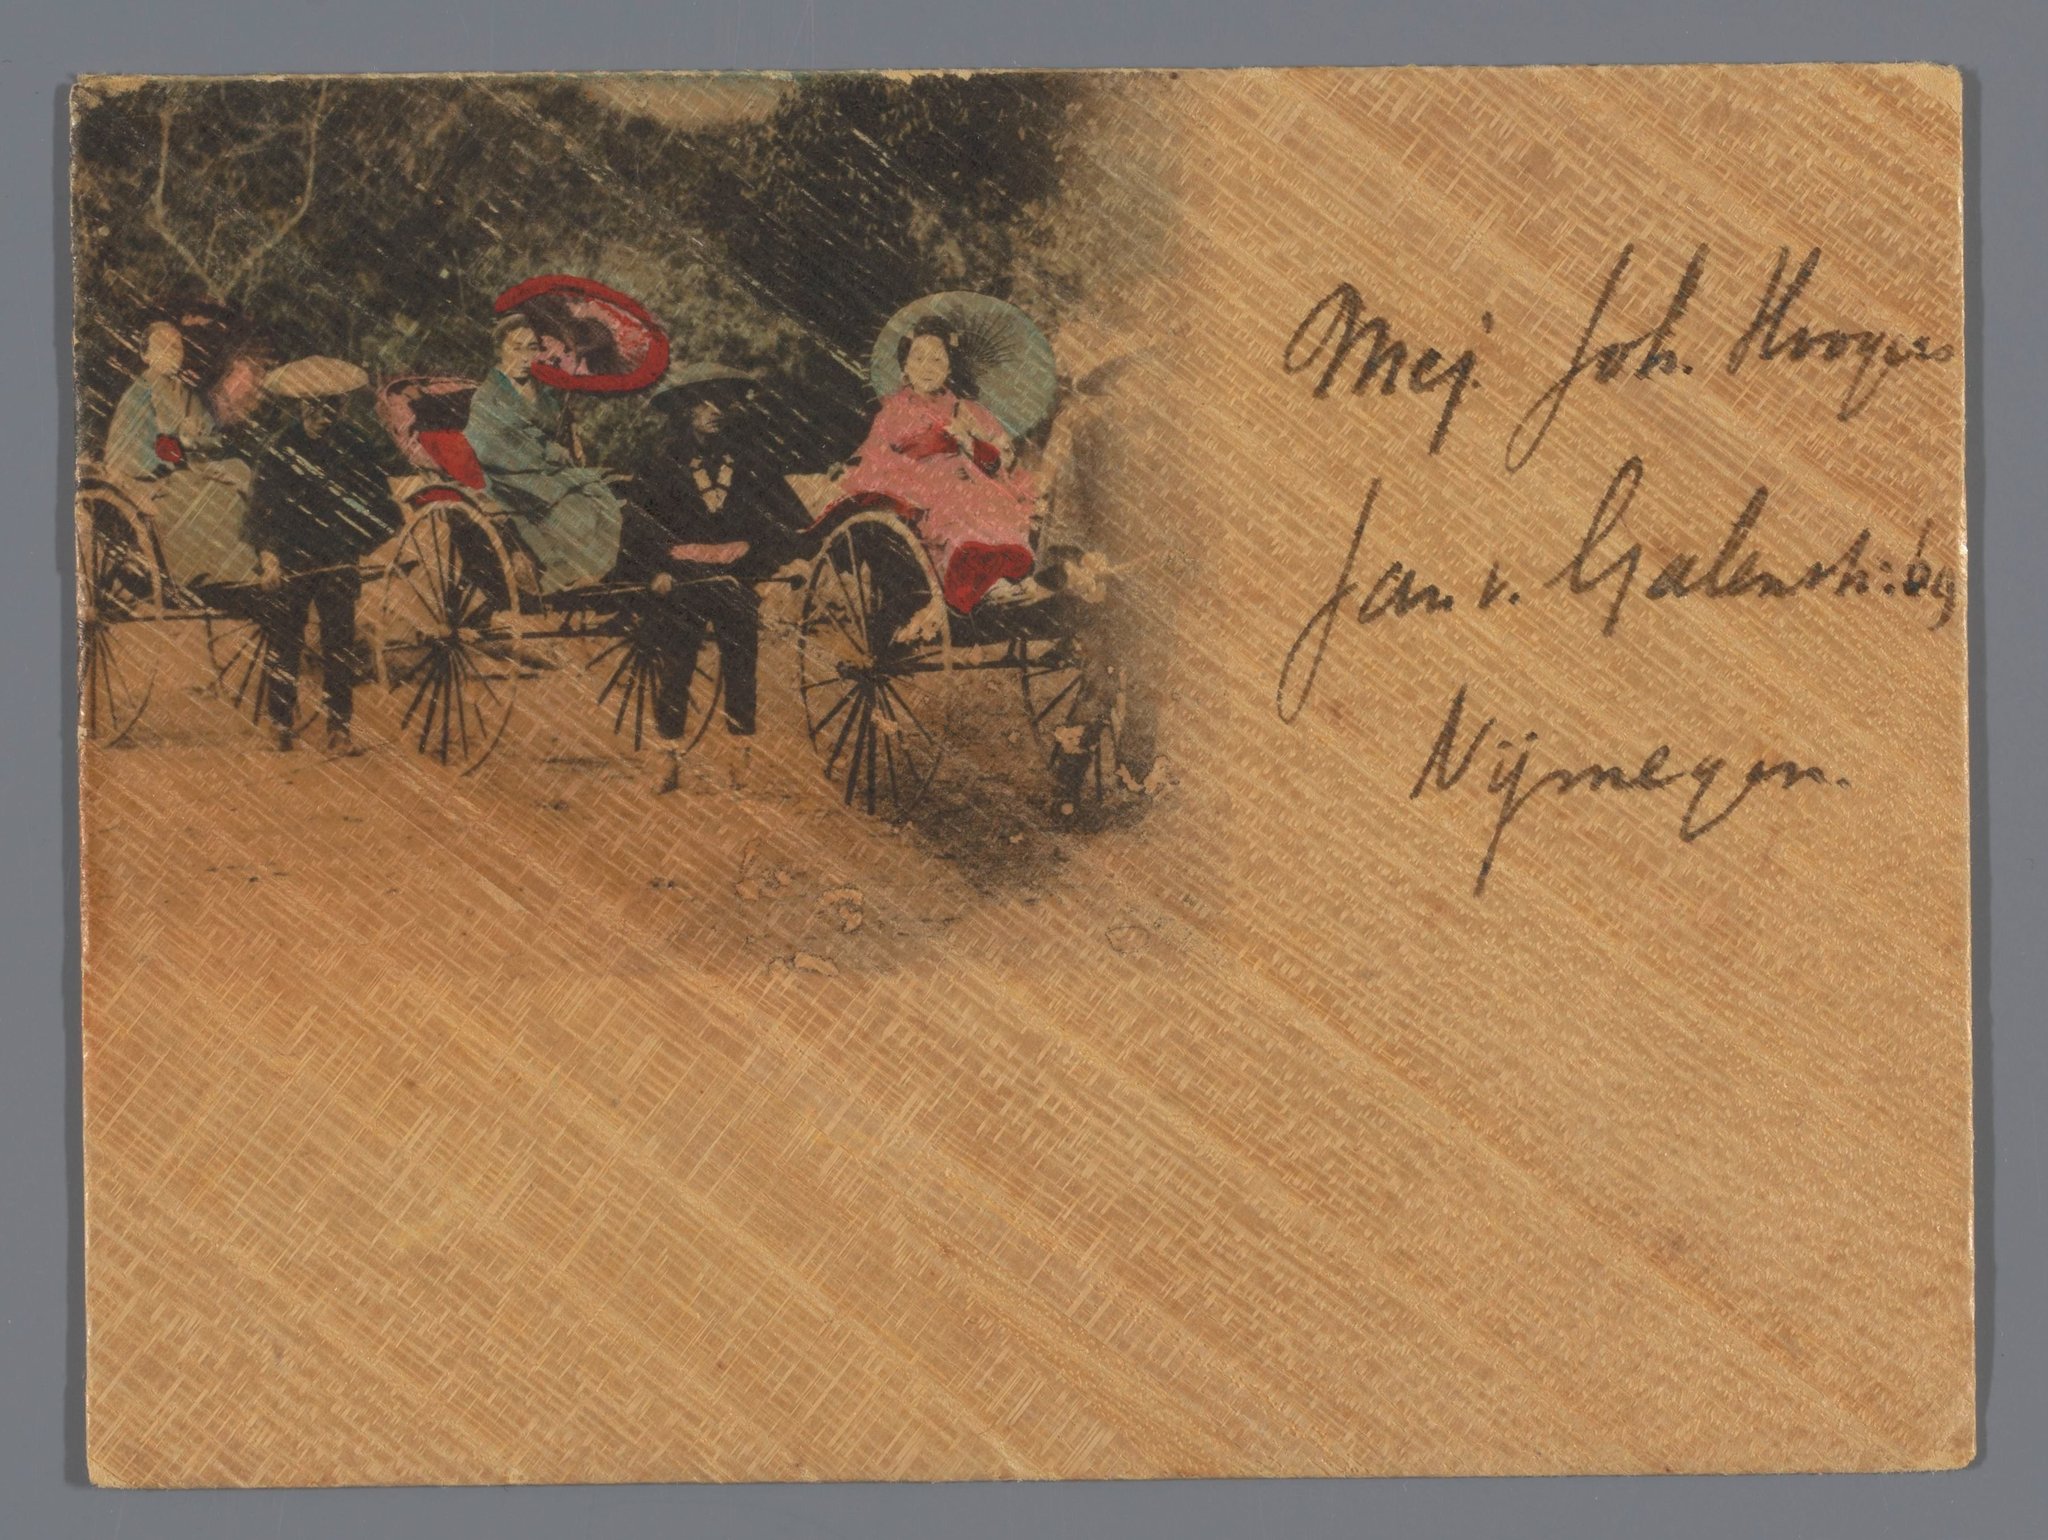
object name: letter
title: Envelop met fotografische voorstelling, gericht aan Johanna Hoogers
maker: Anonymous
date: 1920-1930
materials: paper, wood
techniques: collotype process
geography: japan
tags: rickshaw, letter, envelope, japan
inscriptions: inscription: ‘Mej. Joh. Hoogers/ fam v. Halen[...]/ Nijmegen.’